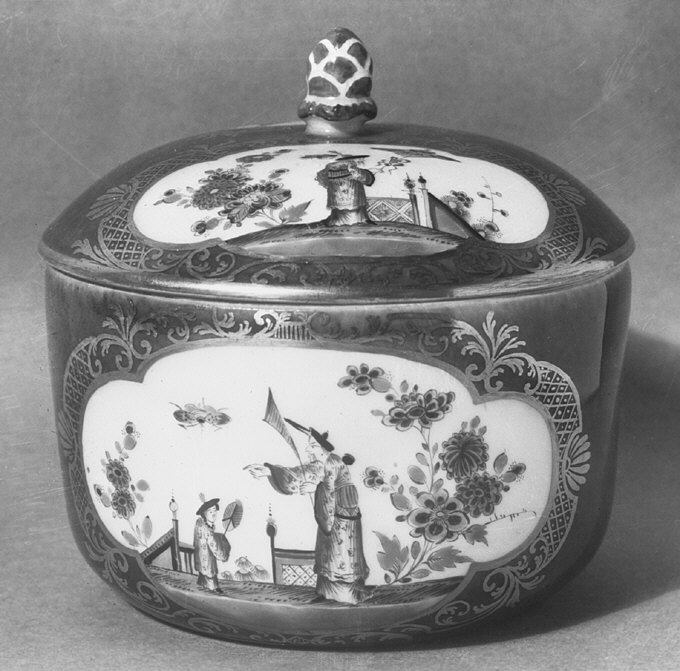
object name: sugar bowl with cover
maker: meissen manufactory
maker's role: manufactory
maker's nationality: german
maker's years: 1710-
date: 1735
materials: hard paste porcelain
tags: chinoiserie,men,insects,flowers